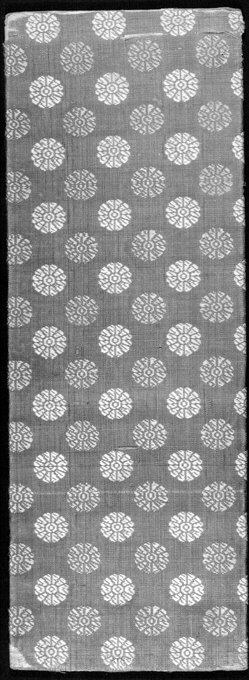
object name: sutra cover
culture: chinese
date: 1501-1600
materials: silk